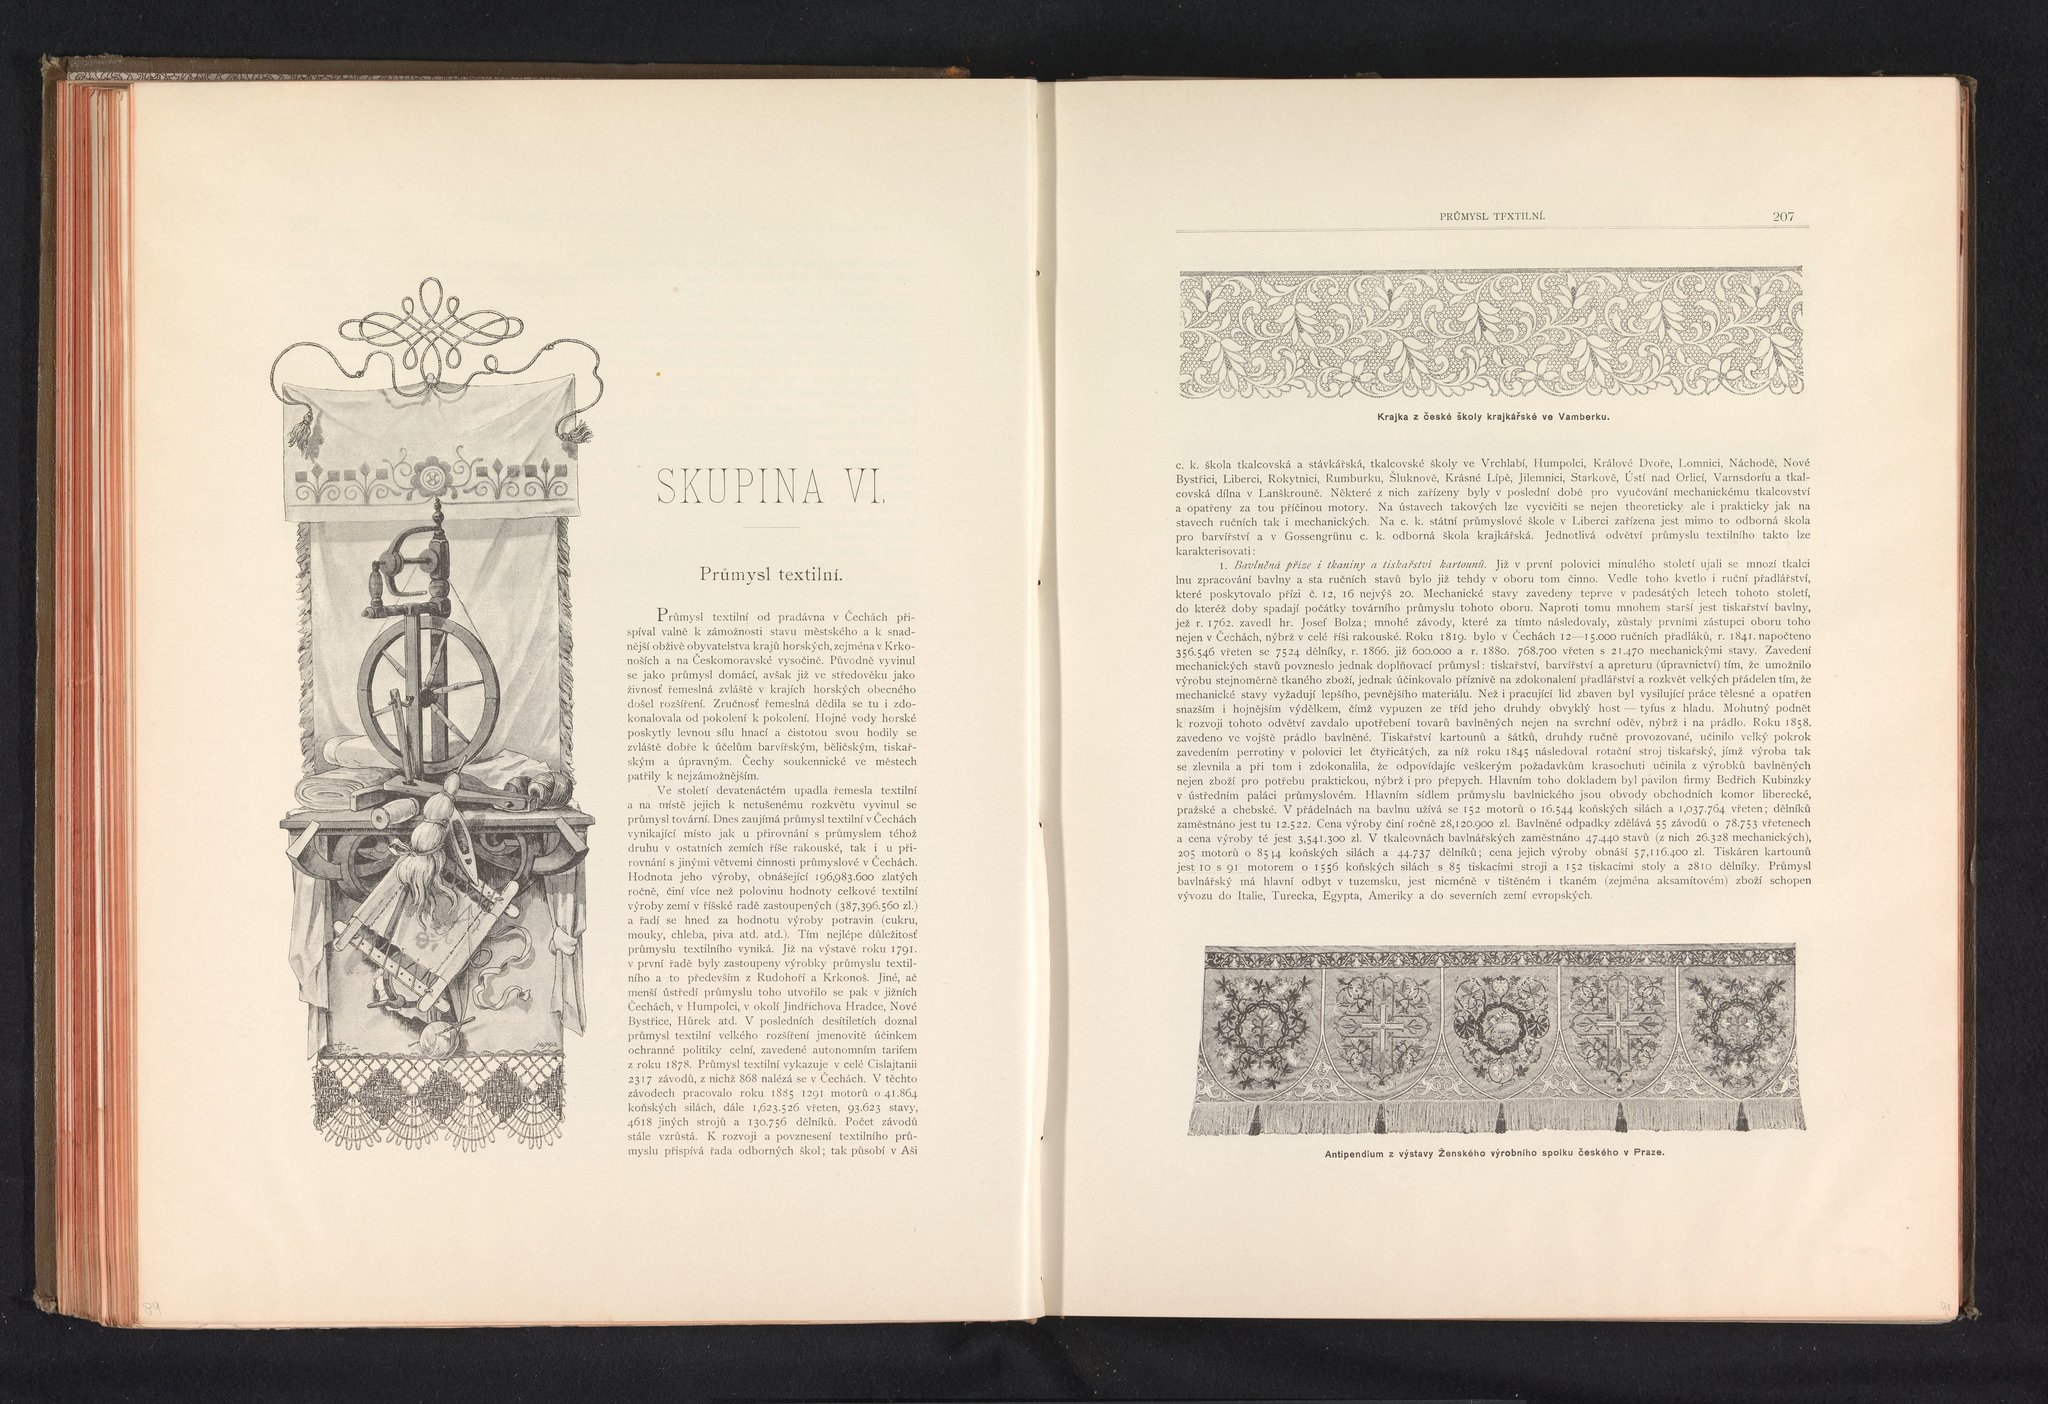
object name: page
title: Fotoreproductie van een tekening, voorstellende een spinnewiel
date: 1890-1895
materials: paper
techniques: autotype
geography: prague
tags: spinning-wheel